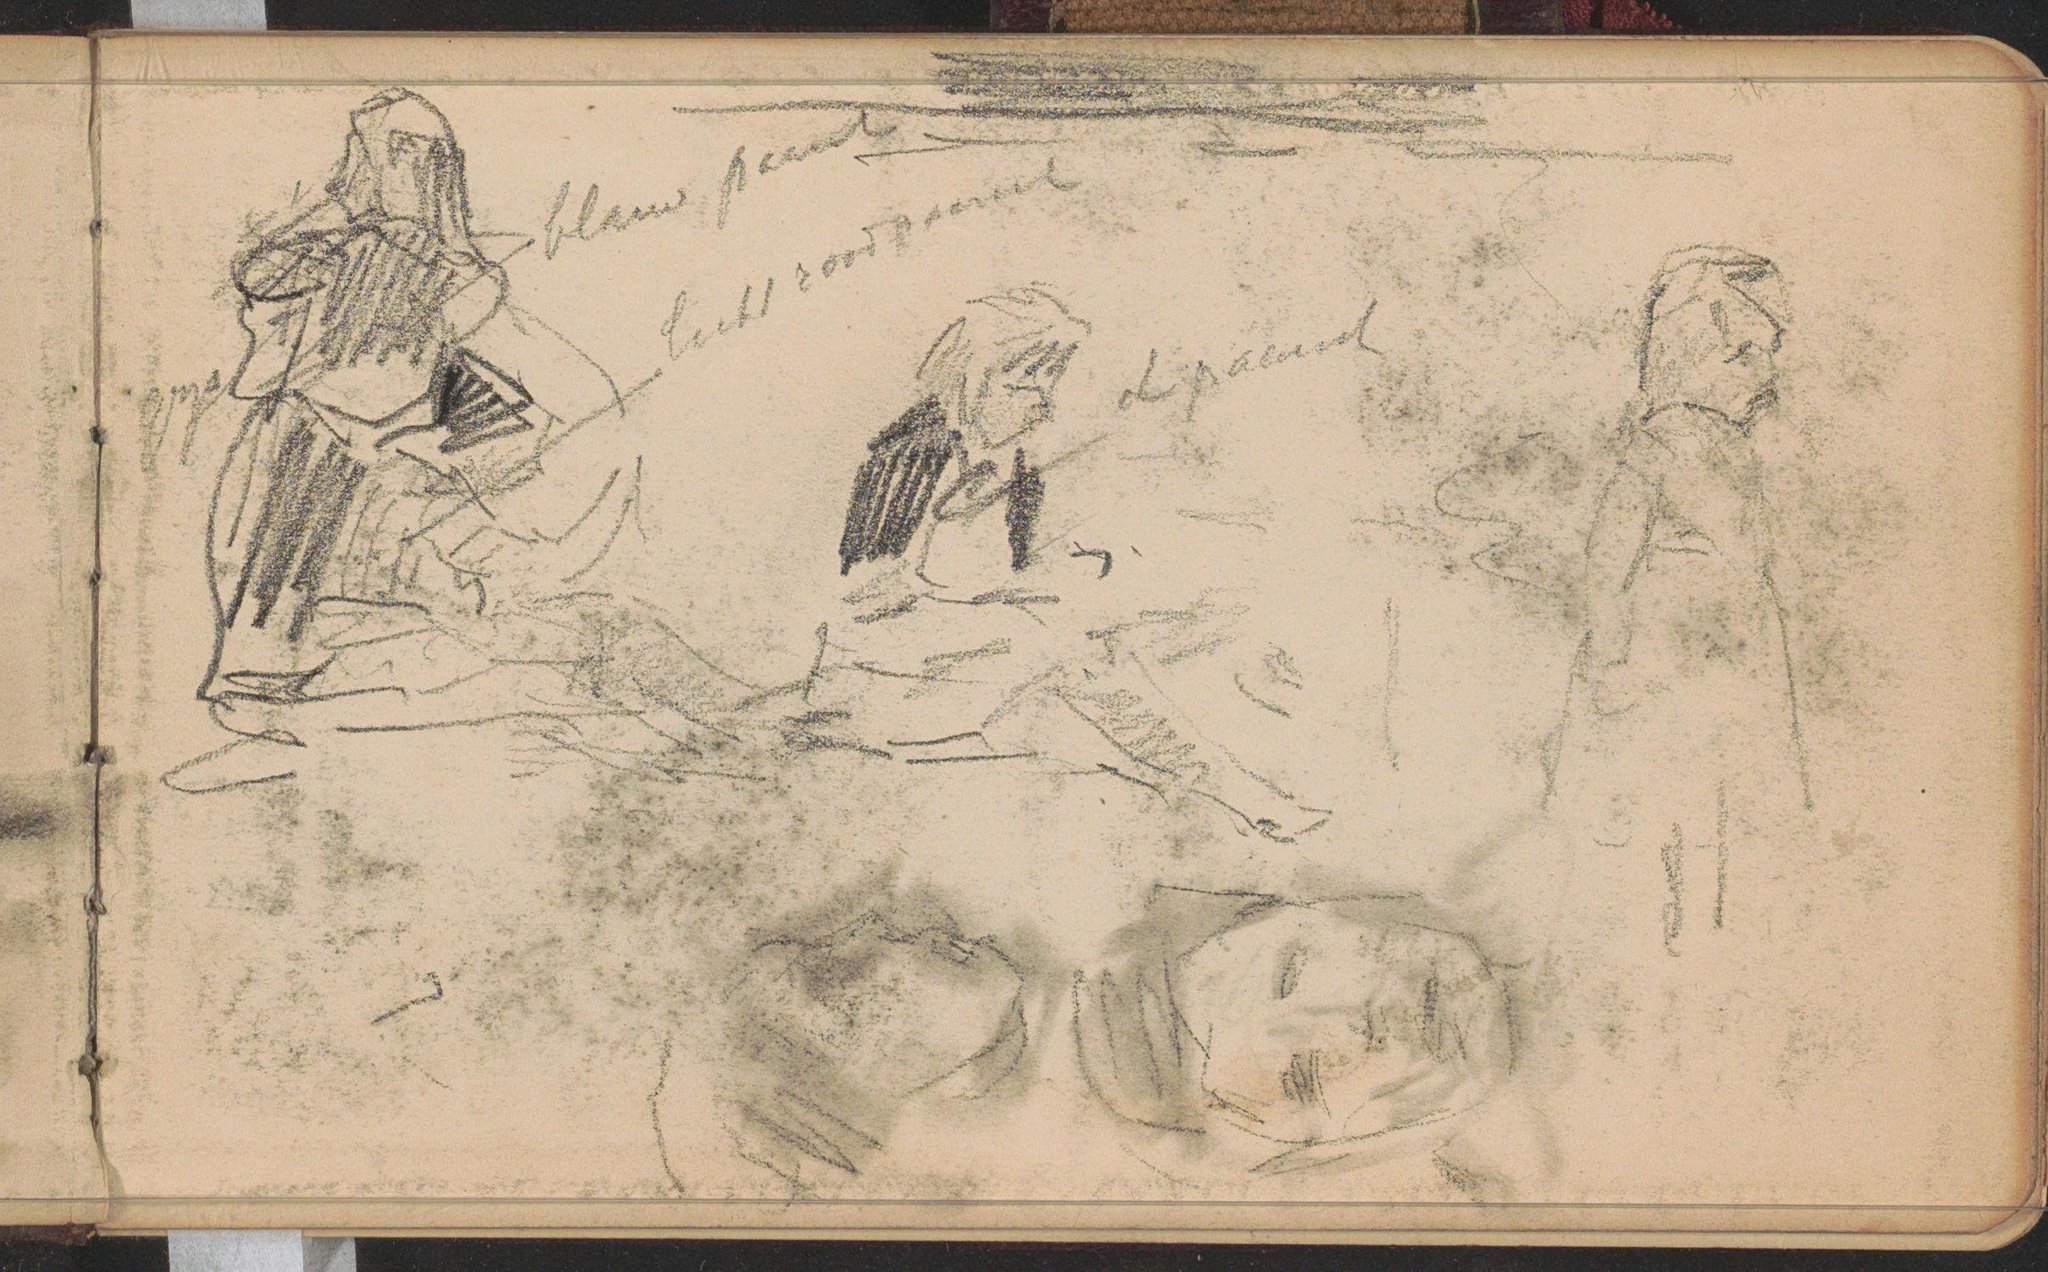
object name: sketchbook leaf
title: Studieblad met figuren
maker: johan antonie de jonge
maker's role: draughtsman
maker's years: 1864-1927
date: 1881-1927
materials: chalk, paper, pencil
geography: south holland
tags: head (human), adult woman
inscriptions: kleurnotitie, handgeschreven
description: Studieblad met figuren. Onder een voor- en zijaanzicht van een mannenhoofd. Blad 1 recto uit een schetsboek met 34 bladen.